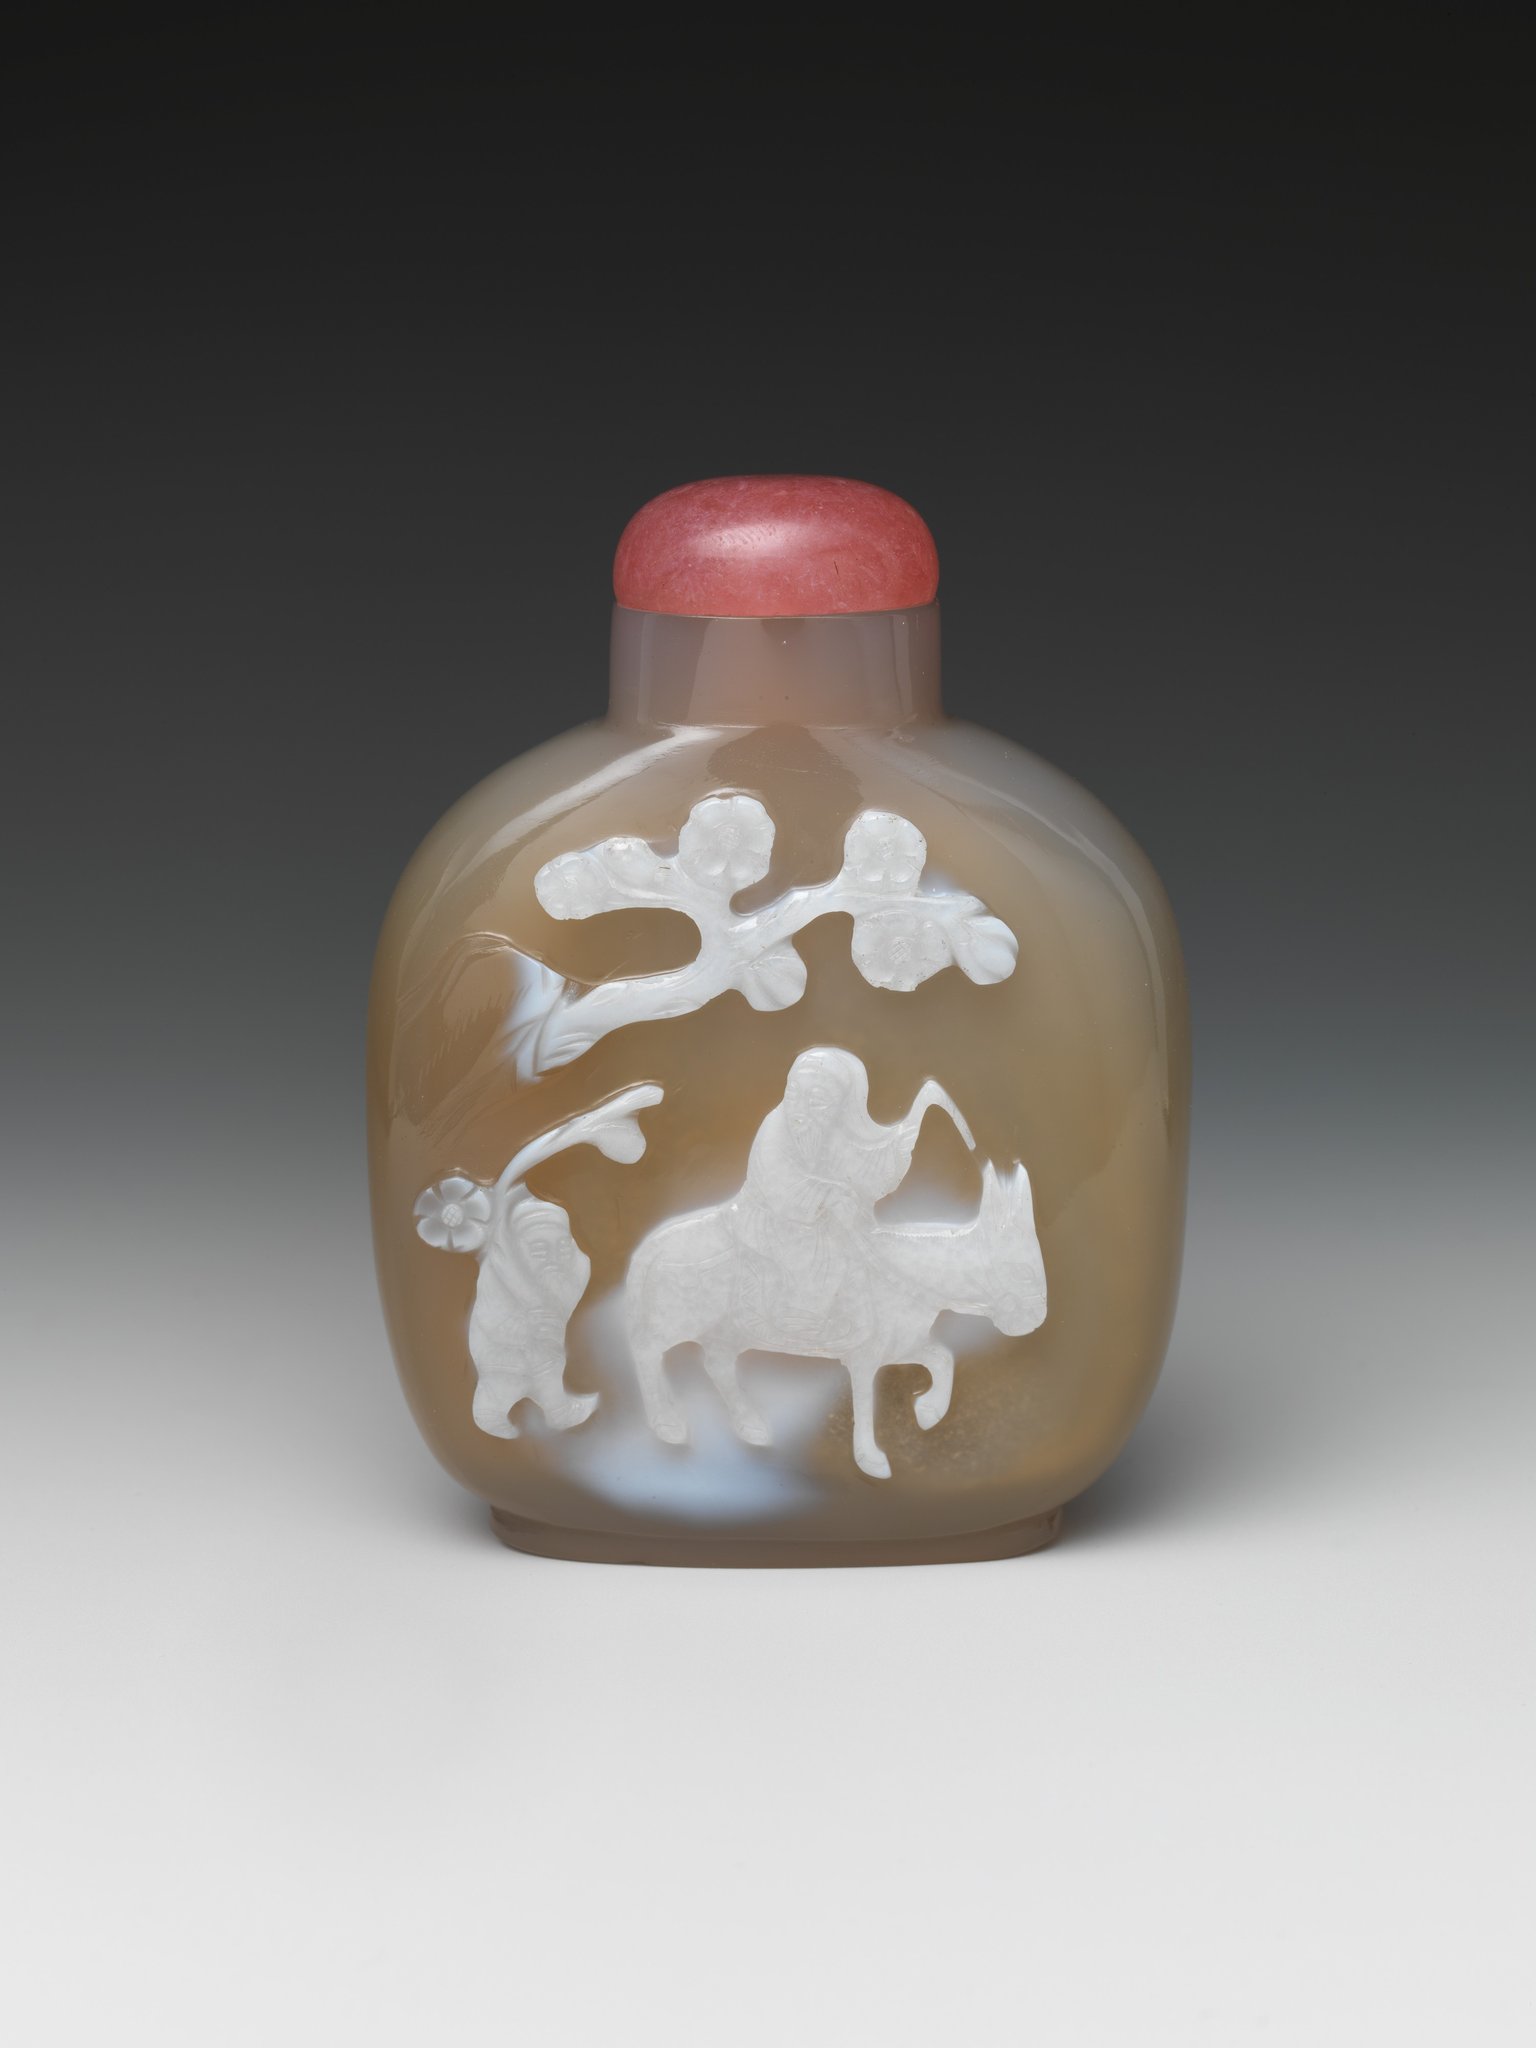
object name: snuff bottle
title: Snuff Bottle with Two Figures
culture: chinese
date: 1801-1833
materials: stone, glass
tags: human figures,animals